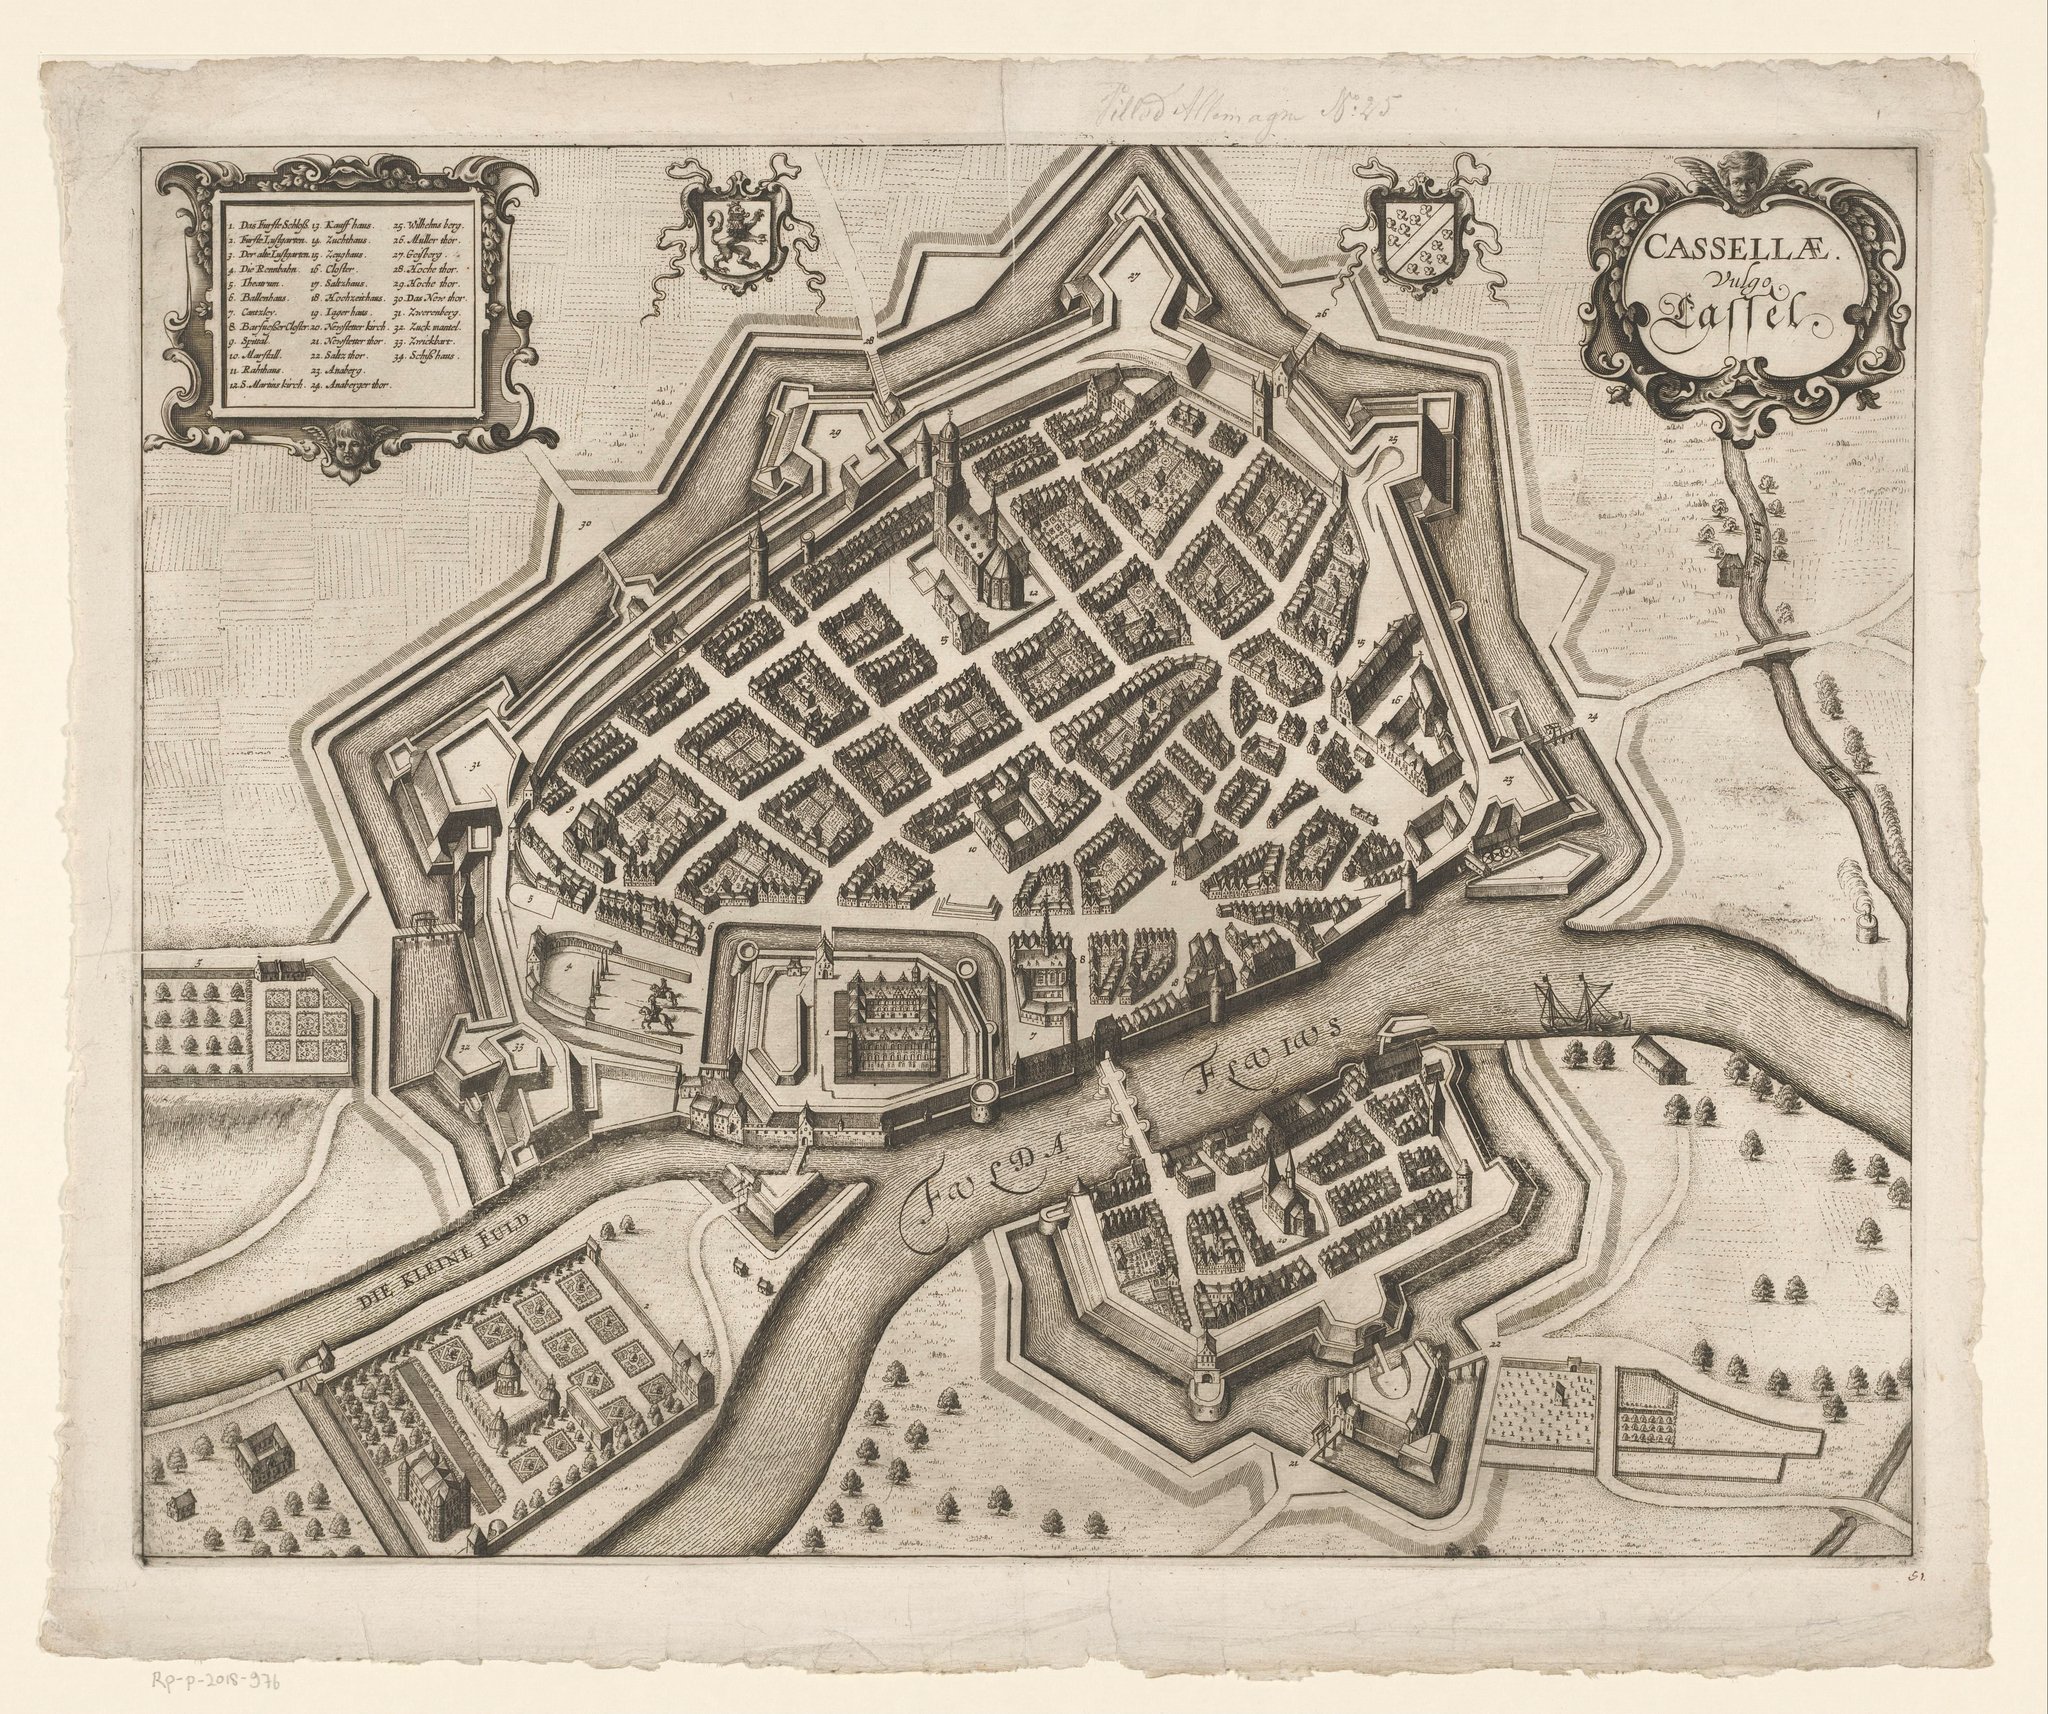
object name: print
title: Plattegrond van Kassel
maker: Anonymous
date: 1657-1728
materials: paper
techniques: engraving, etching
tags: coat of arms (as symbol of the state, etc.) (+ city; municipal), maps of cities, coat of arms (as symbol of the state, etc.) (+ province; provincial)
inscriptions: collector's mark: Lugt 2228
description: Plattegrond van Kassel in vogelvlucht perspectief. Boven, links van het midden, het wapen van Hessen. Boven, rechts van het midden, het wapen van Kassel.